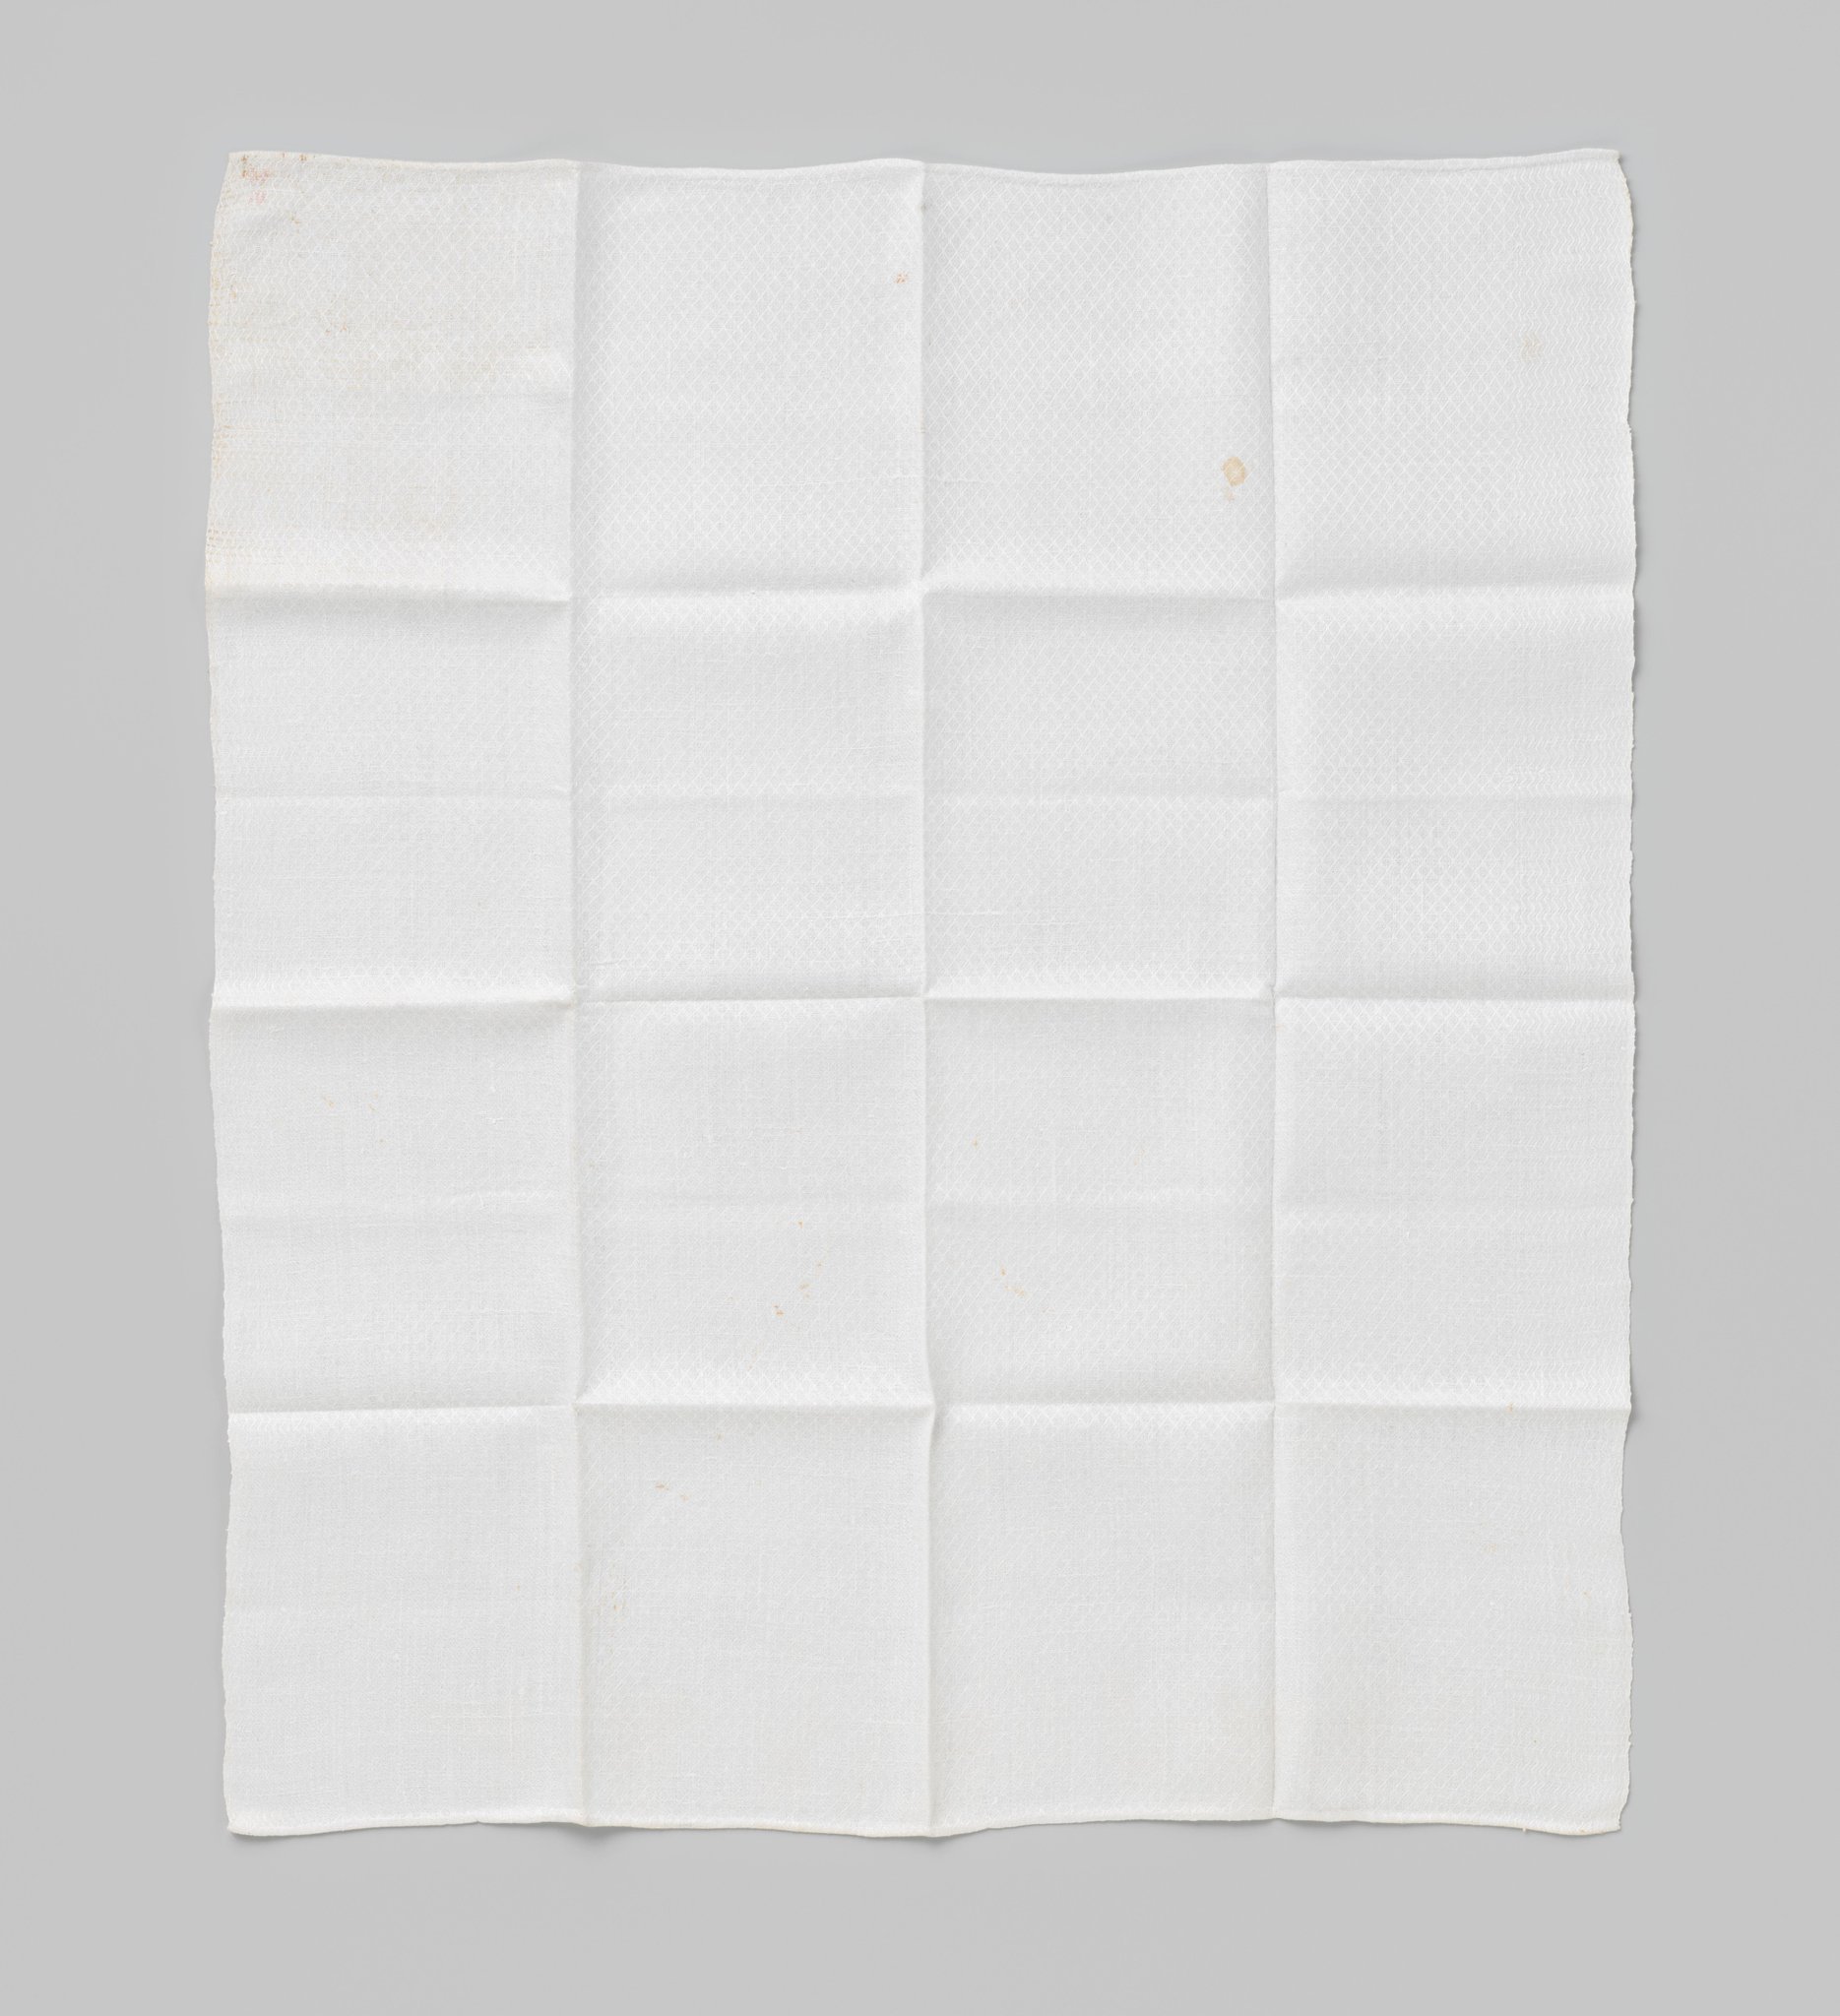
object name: cloth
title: Keukendoek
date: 1800-1860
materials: linen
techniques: peeled fabric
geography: netherlands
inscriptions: mark: ‘HP10’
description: Linnen doek, pellen, kraanoog, voor gebruik in de keuken. Gemerkt HP10.